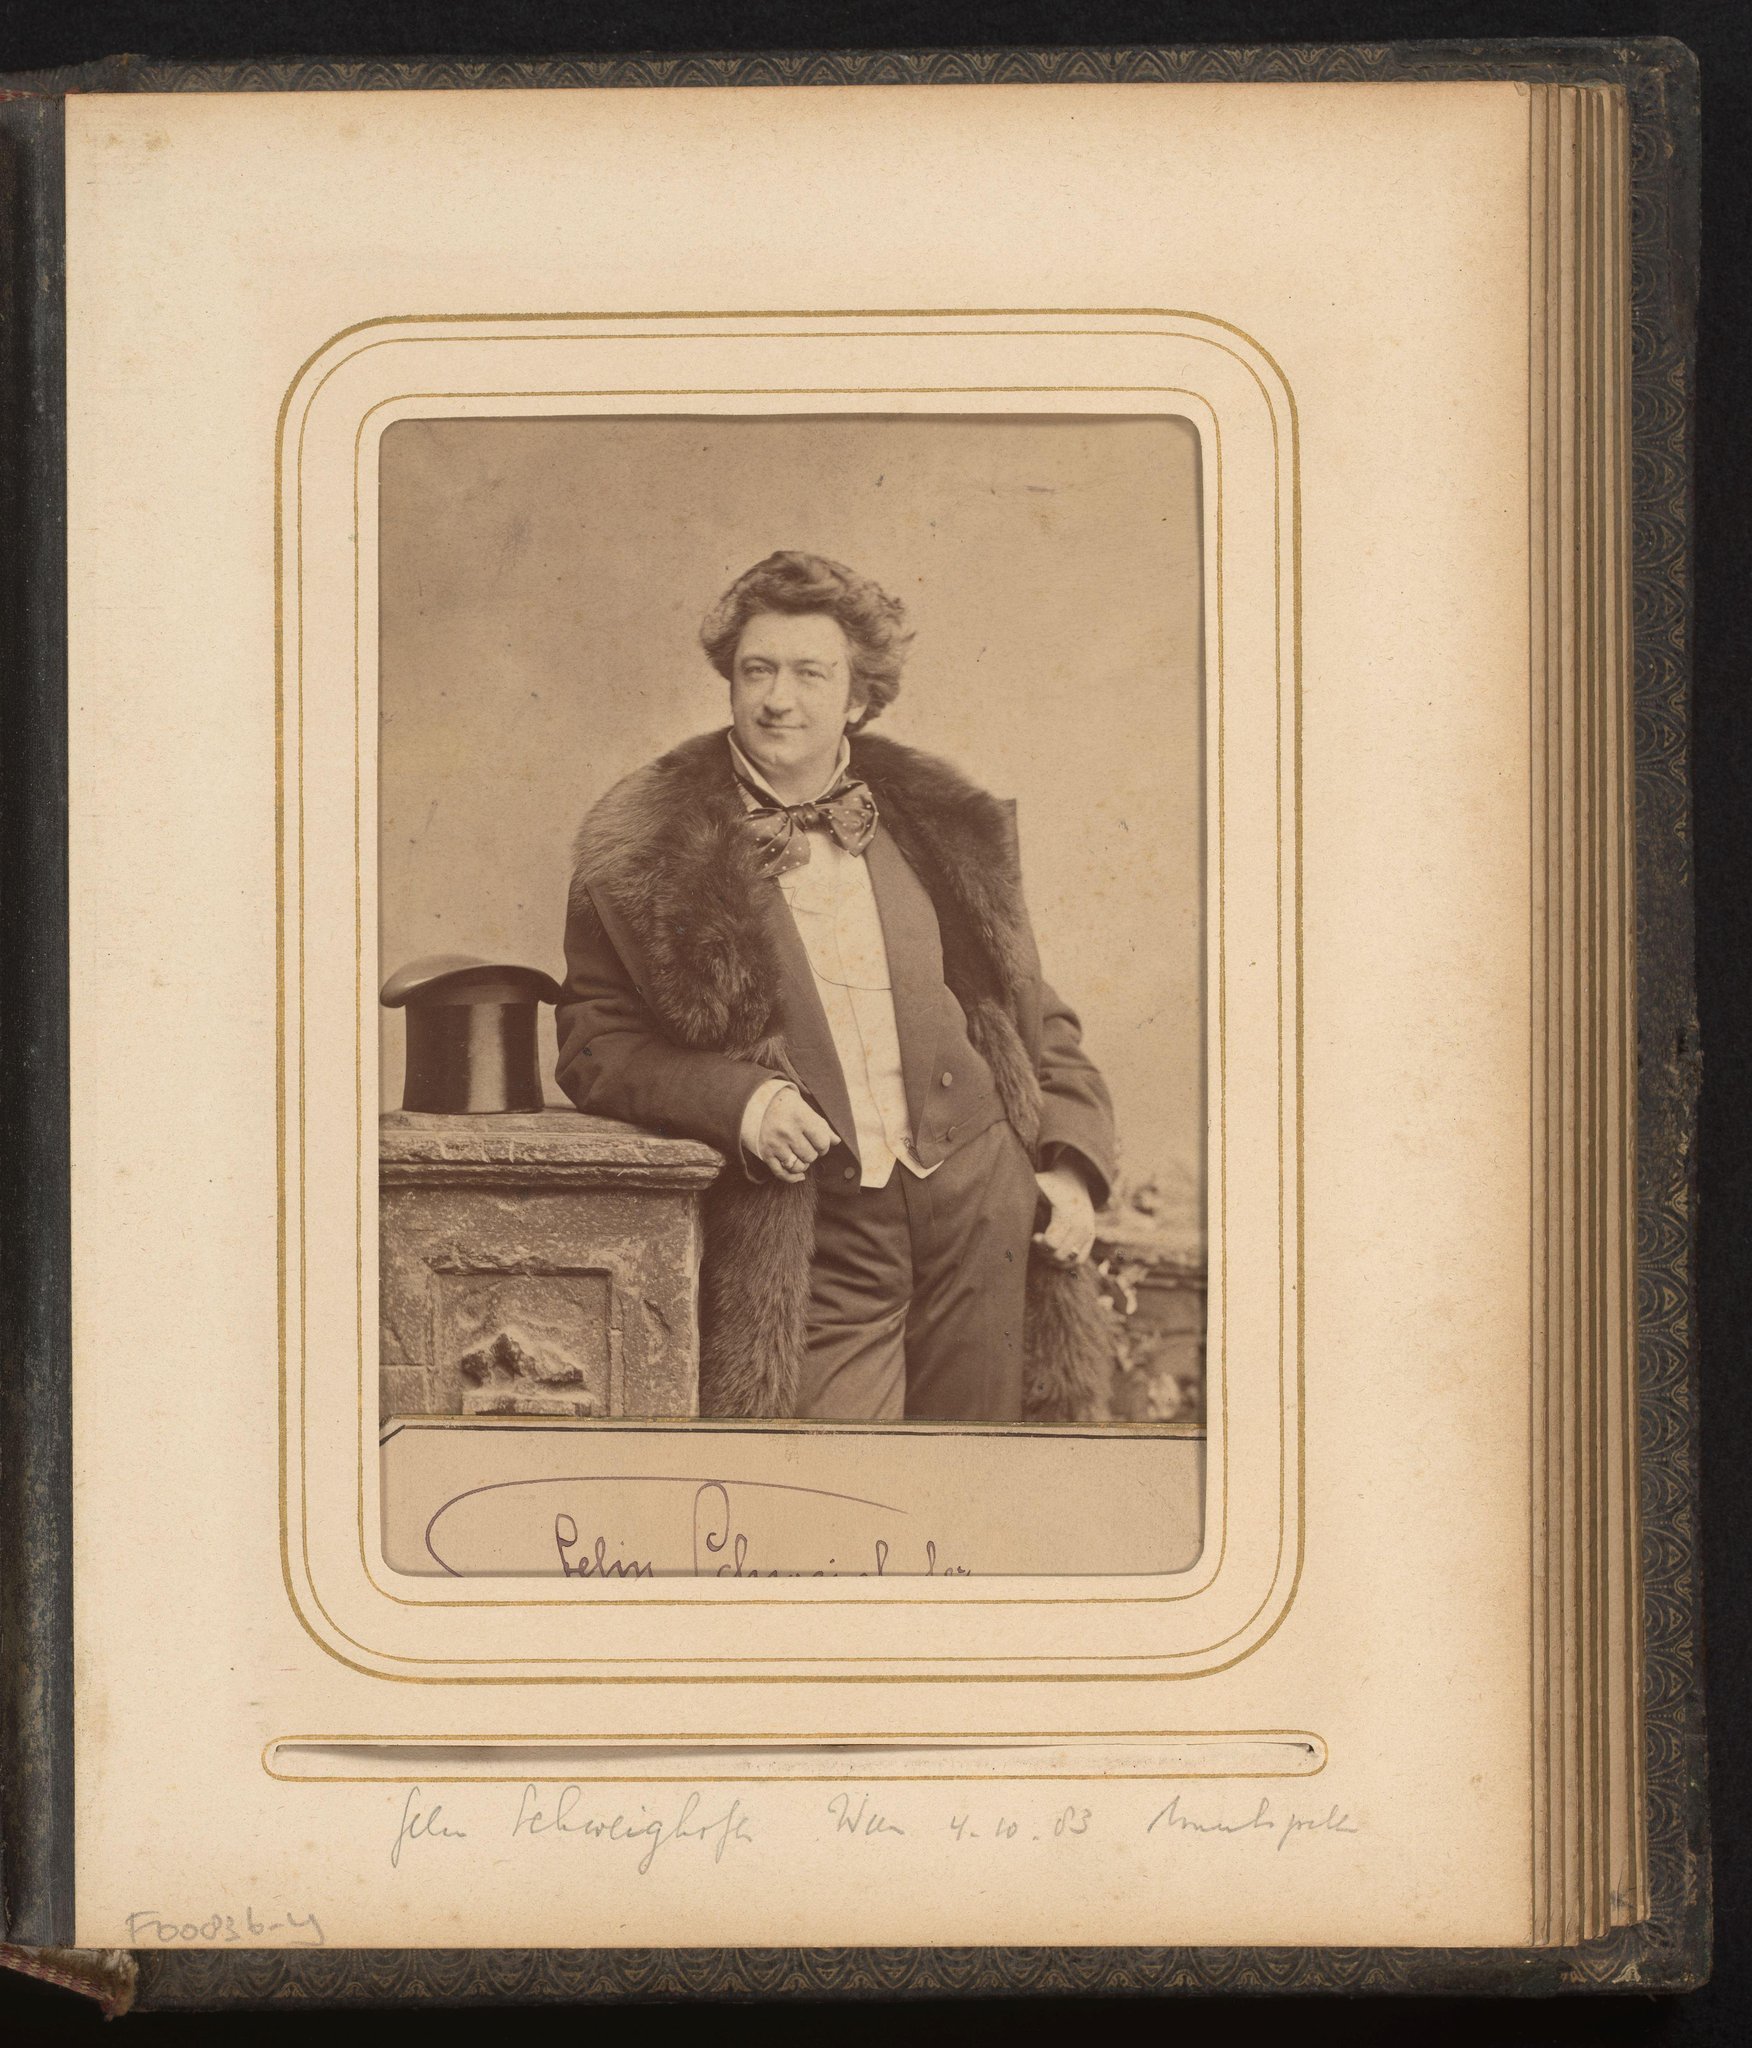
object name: cabinet photograph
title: Portret van Felix Schweighofer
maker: carl krziwanek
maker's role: print maker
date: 1883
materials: cardboard, photographic support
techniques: albumen print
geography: ischl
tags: historical persons, portrait of actor, actress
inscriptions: annotation: ‘Felix Schweighofer’, inscription: ‘Wien/ Neubau/ Hofstallstrasse 5/ nächst hôtel höller/ Krziwanek/ Franzensallee 10 Ischl’, annotation: ‘Felix Schweighofer Wien 4.10.83 [...]’